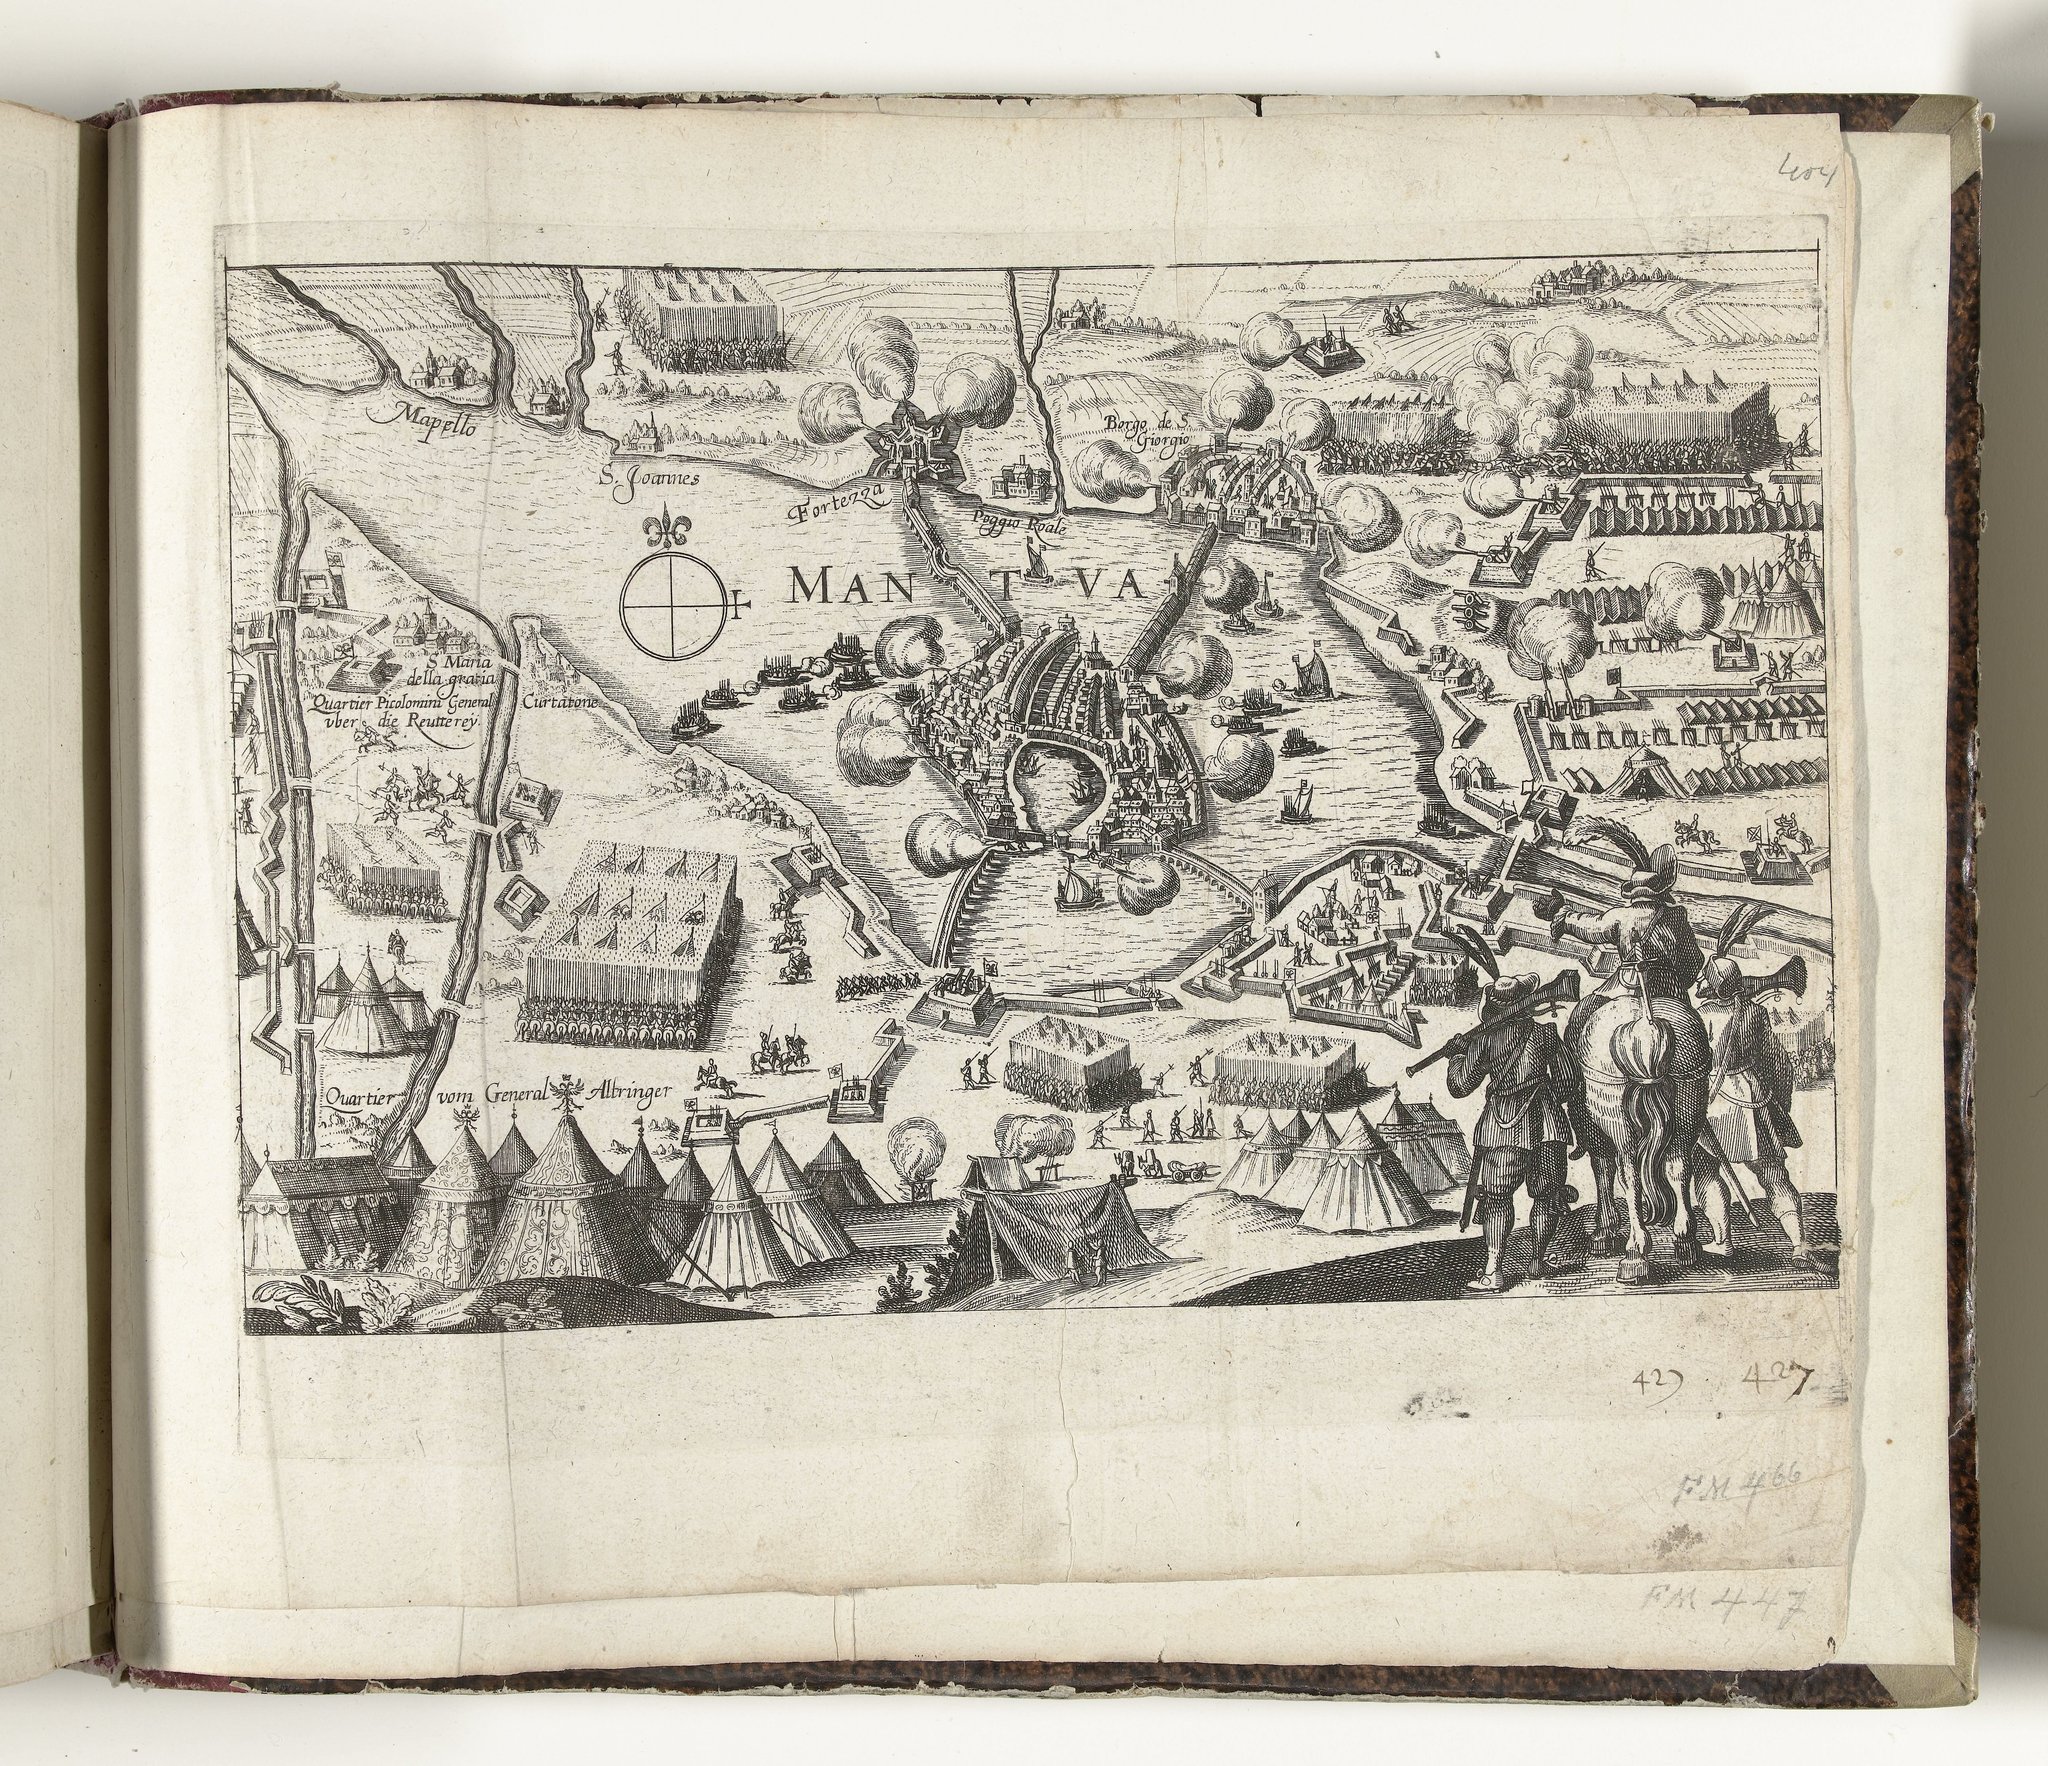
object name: print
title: Serie 11: Varia Buitenlandse Gebeurtenissen, 1571-1631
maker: frans hogenberg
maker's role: print maker, publisher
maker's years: 1538-1590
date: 1629-1632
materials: paper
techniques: etching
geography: cologne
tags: siege, position war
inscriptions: inscription: ‘427 427’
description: Beleg van Mantua door het keizerlijke leger, 1629-1630. Gezicht op de stad vanuit het legerlamp van de belegeraars. Zonder onderschrift. Rechtsonder met pen genummerd: 427. De prent maakt deel uit van een album.